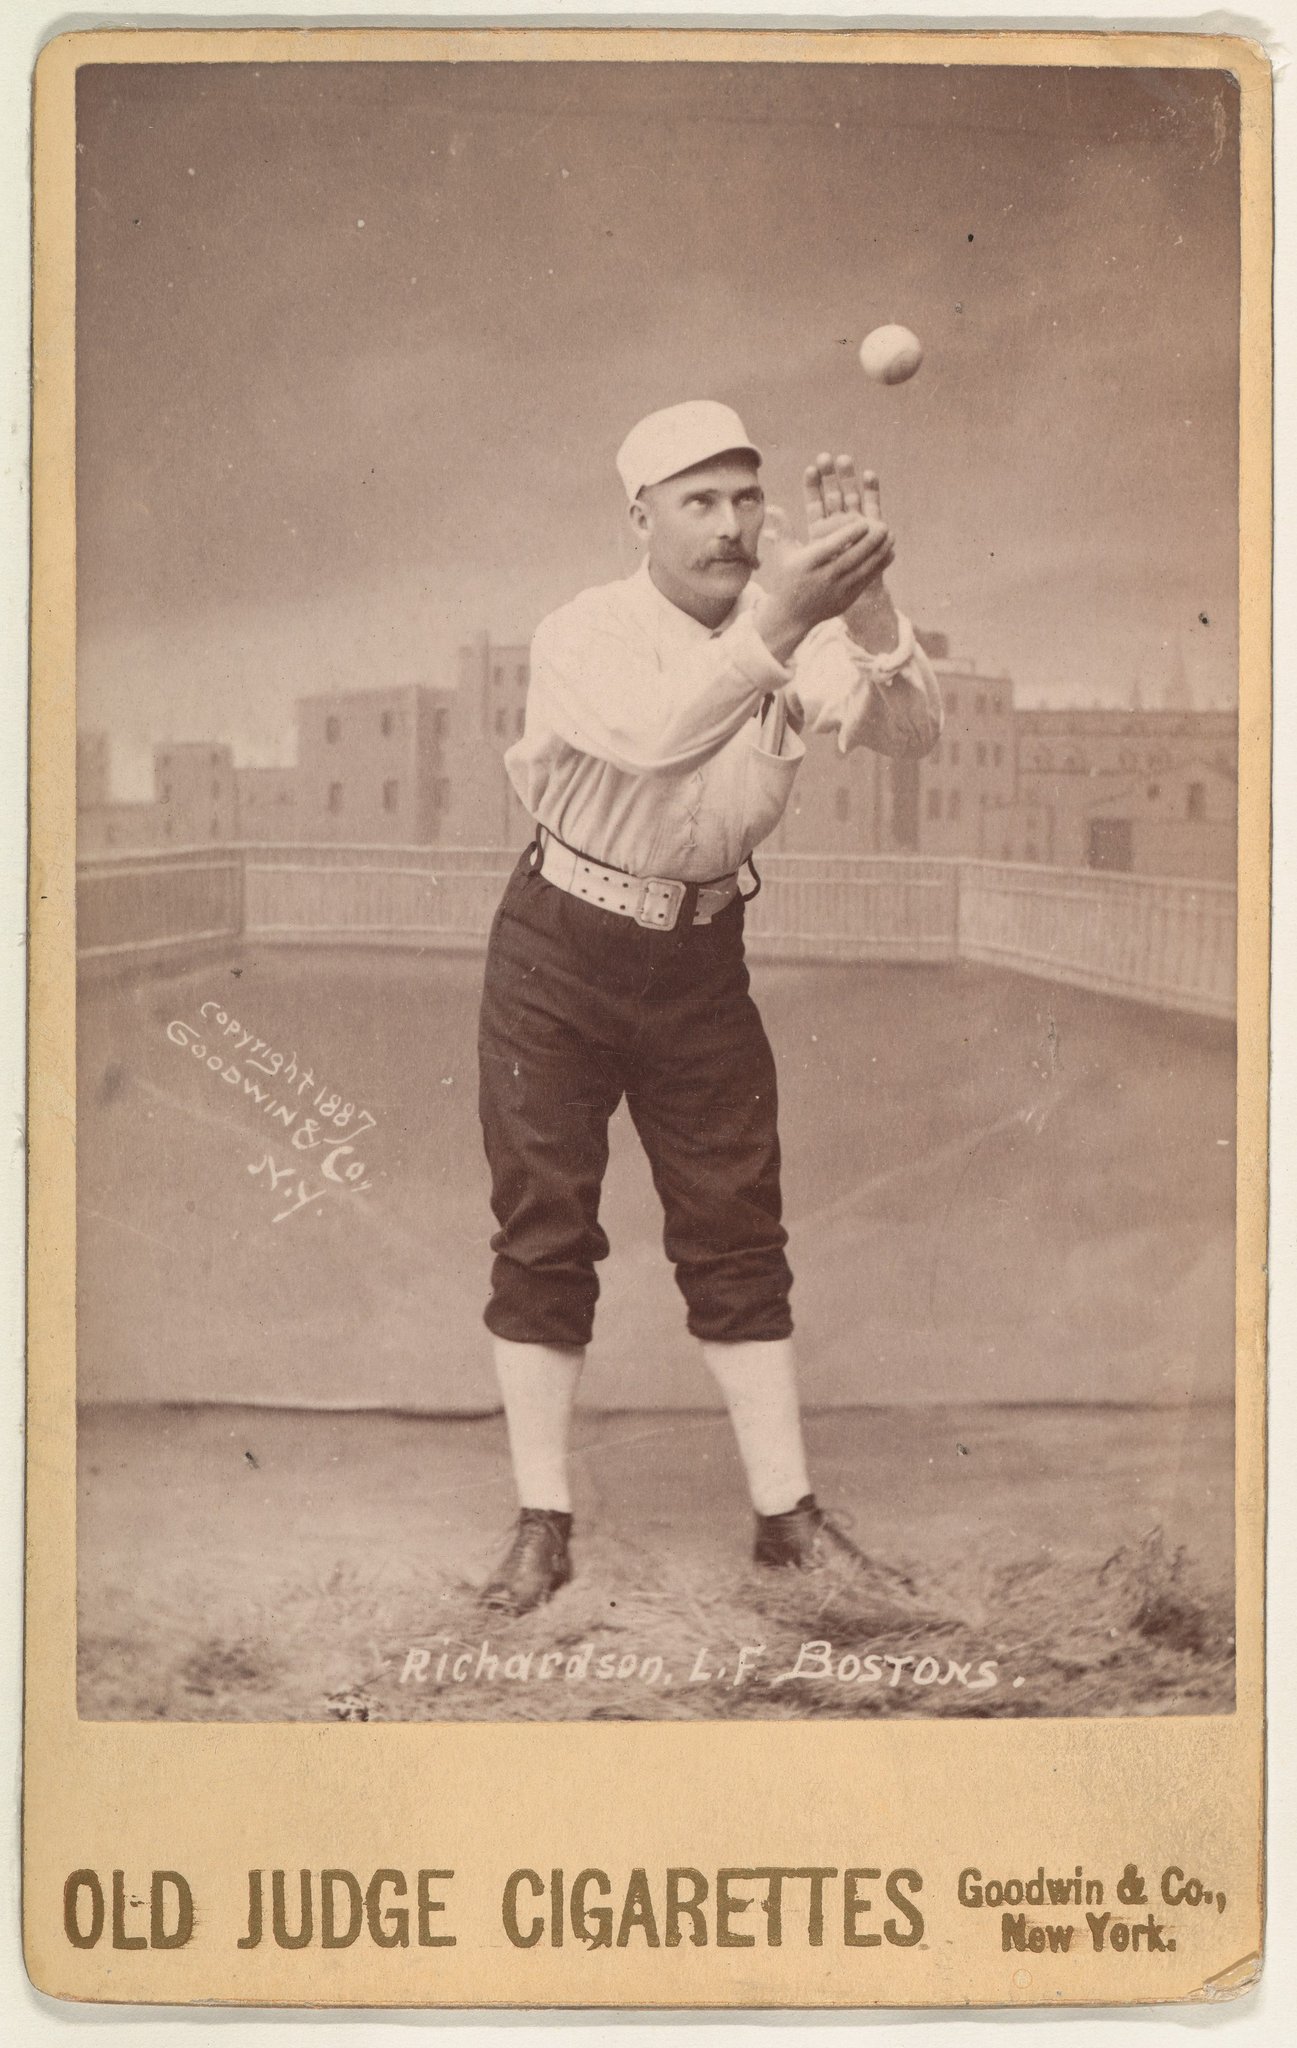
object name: baseball card, photograph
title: Richardson, Left Field, Boston, from the series Old Judge Cigarettes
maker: goodwin & company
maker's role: publisher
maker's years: 1850-1950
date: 1888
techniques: albumen print, photography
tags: men,portraits,baseball,athletes